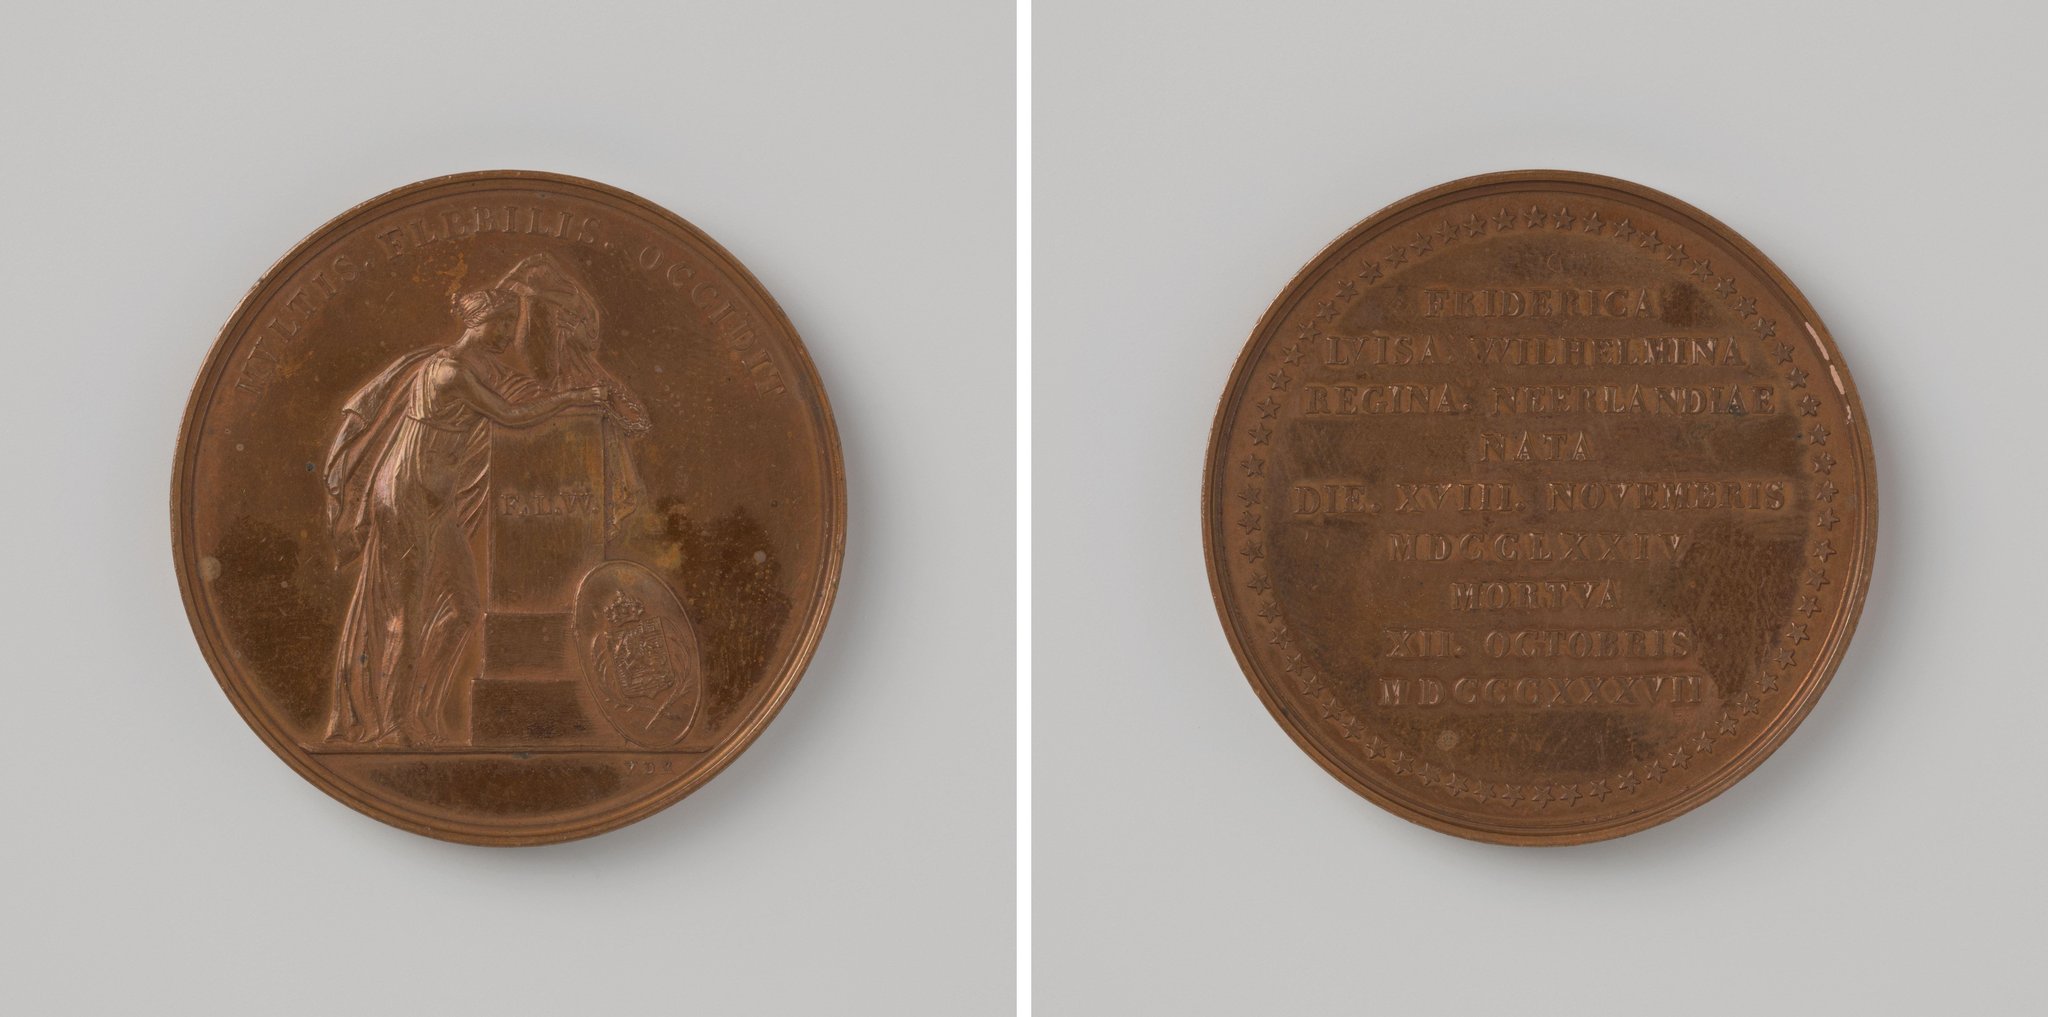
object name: history medal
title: Overlijden van koningin Frederica Louise Wilhelmina der Nederlanden, vrouw van Koning Willem I 1837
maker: david van der kellen (1804-1879)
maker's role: die cutter, draughtsman, print maker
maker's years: 1804-1879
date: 1835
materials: bronze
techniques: striking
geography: utrecht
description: Bronzen penning, op de voorzijde Nederland als vrouw die een zuil met asurn omhelst, met omschrift, op de keerzijde negen regels tekst binnen een kans van 62 sterren.